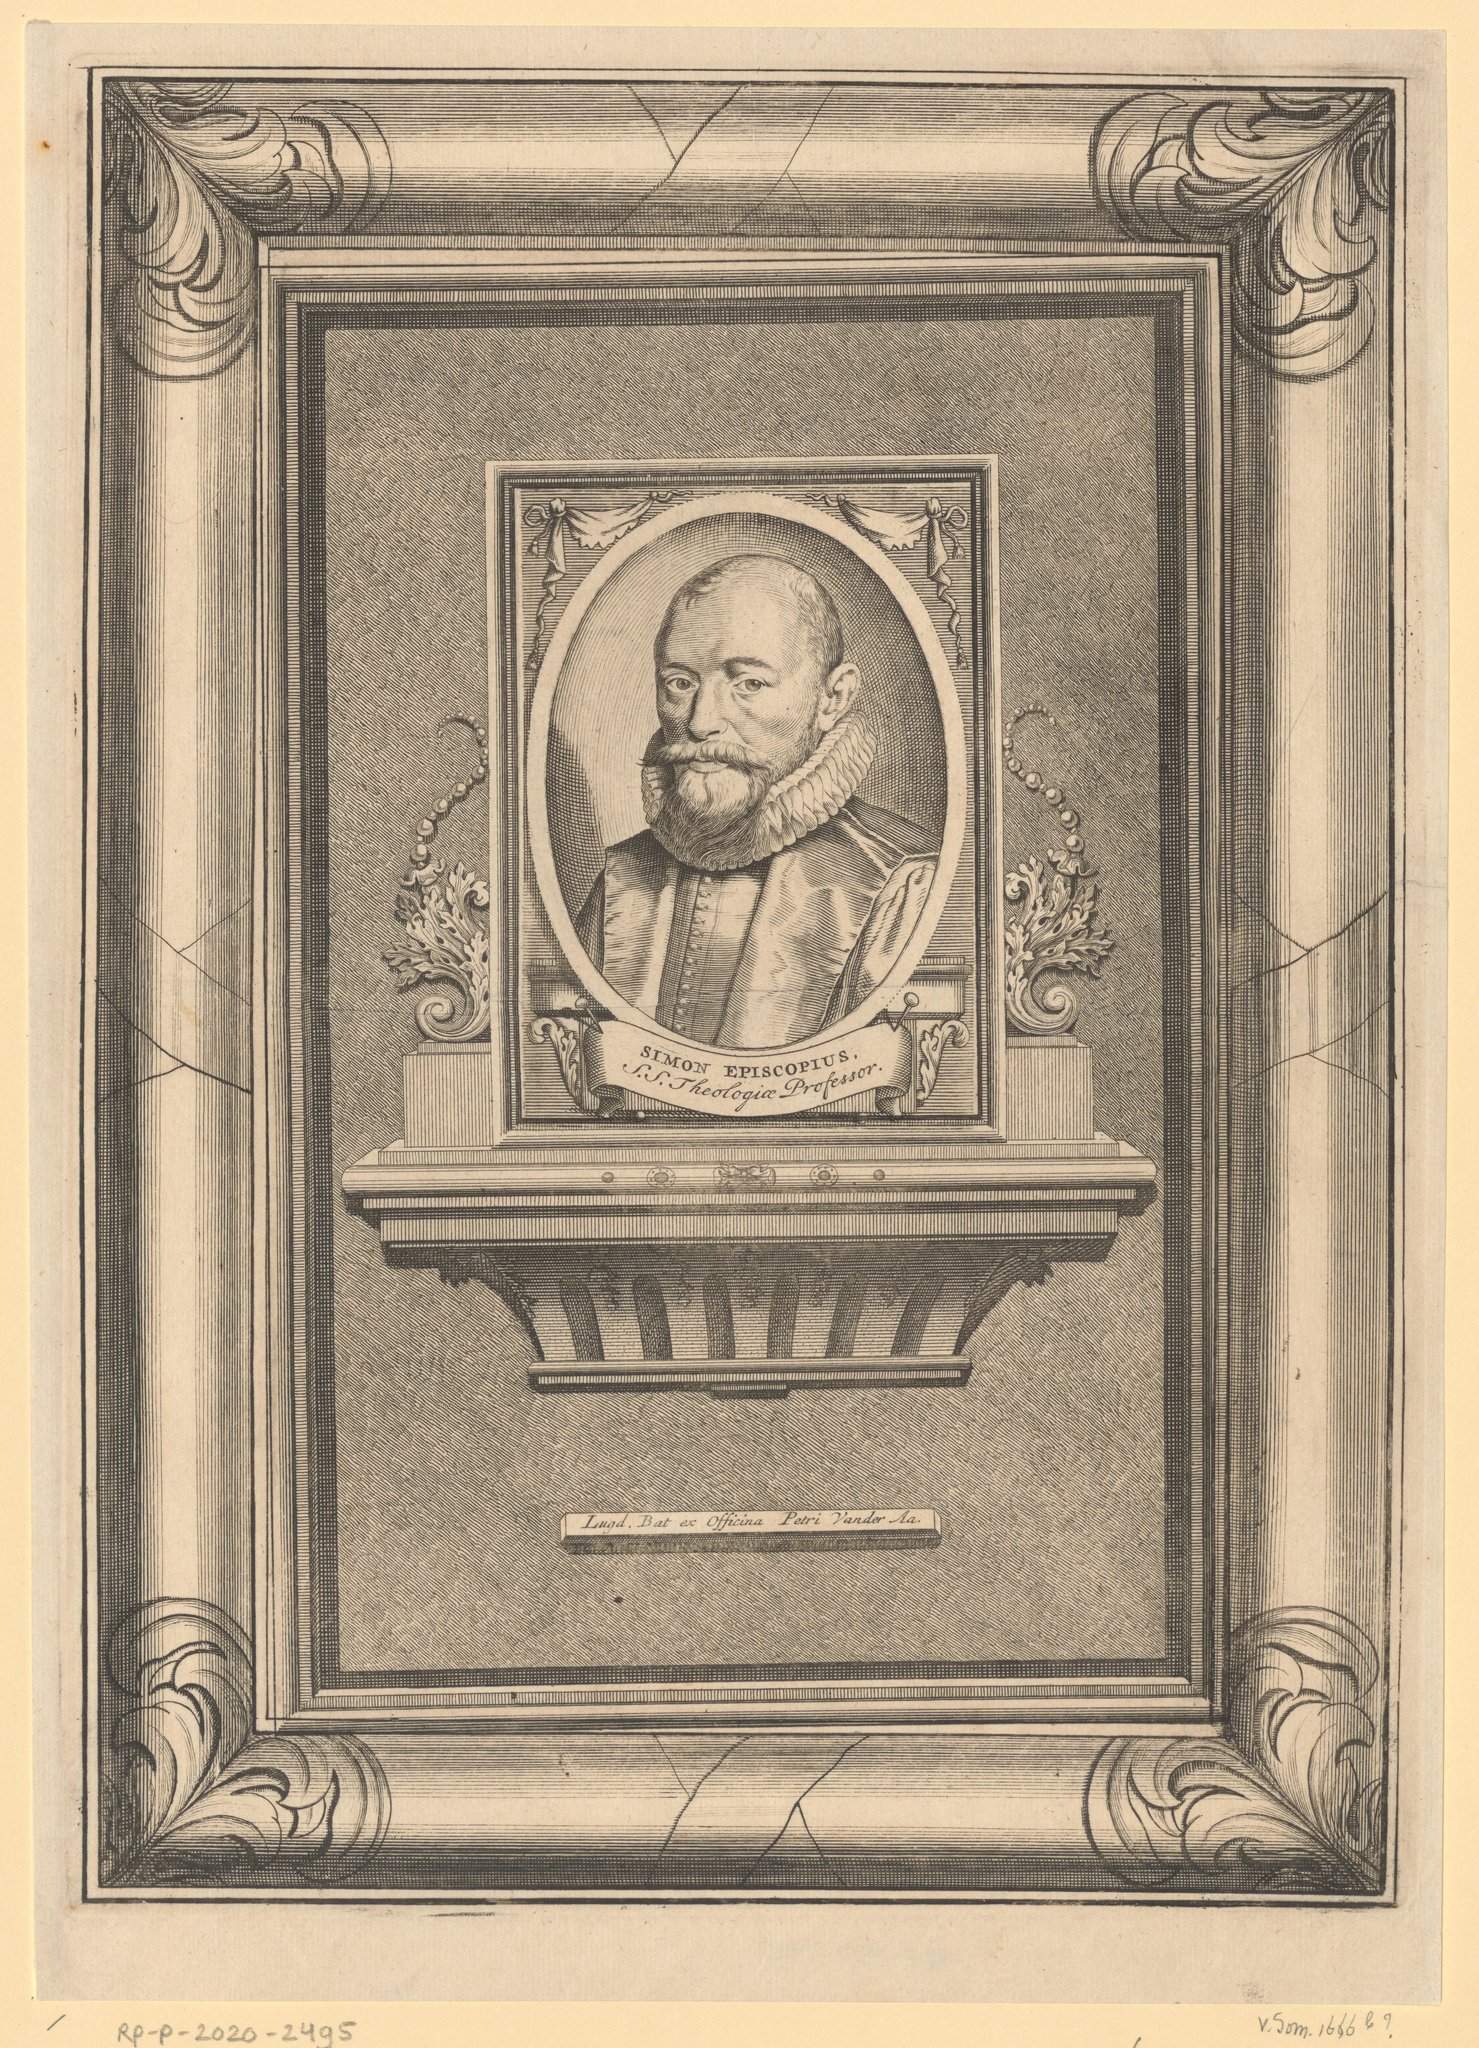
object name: print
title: Fundatoris, curatorum et professorum celeberrimorum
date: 1716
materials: paper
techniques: engraving, etching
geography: leiden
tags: amsterdam, theologian, historical persons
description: Prent vermoedelijk gebruikt in een eerdere staat in een prentenserie uit 1614, zie ook Van Someren, 1888.